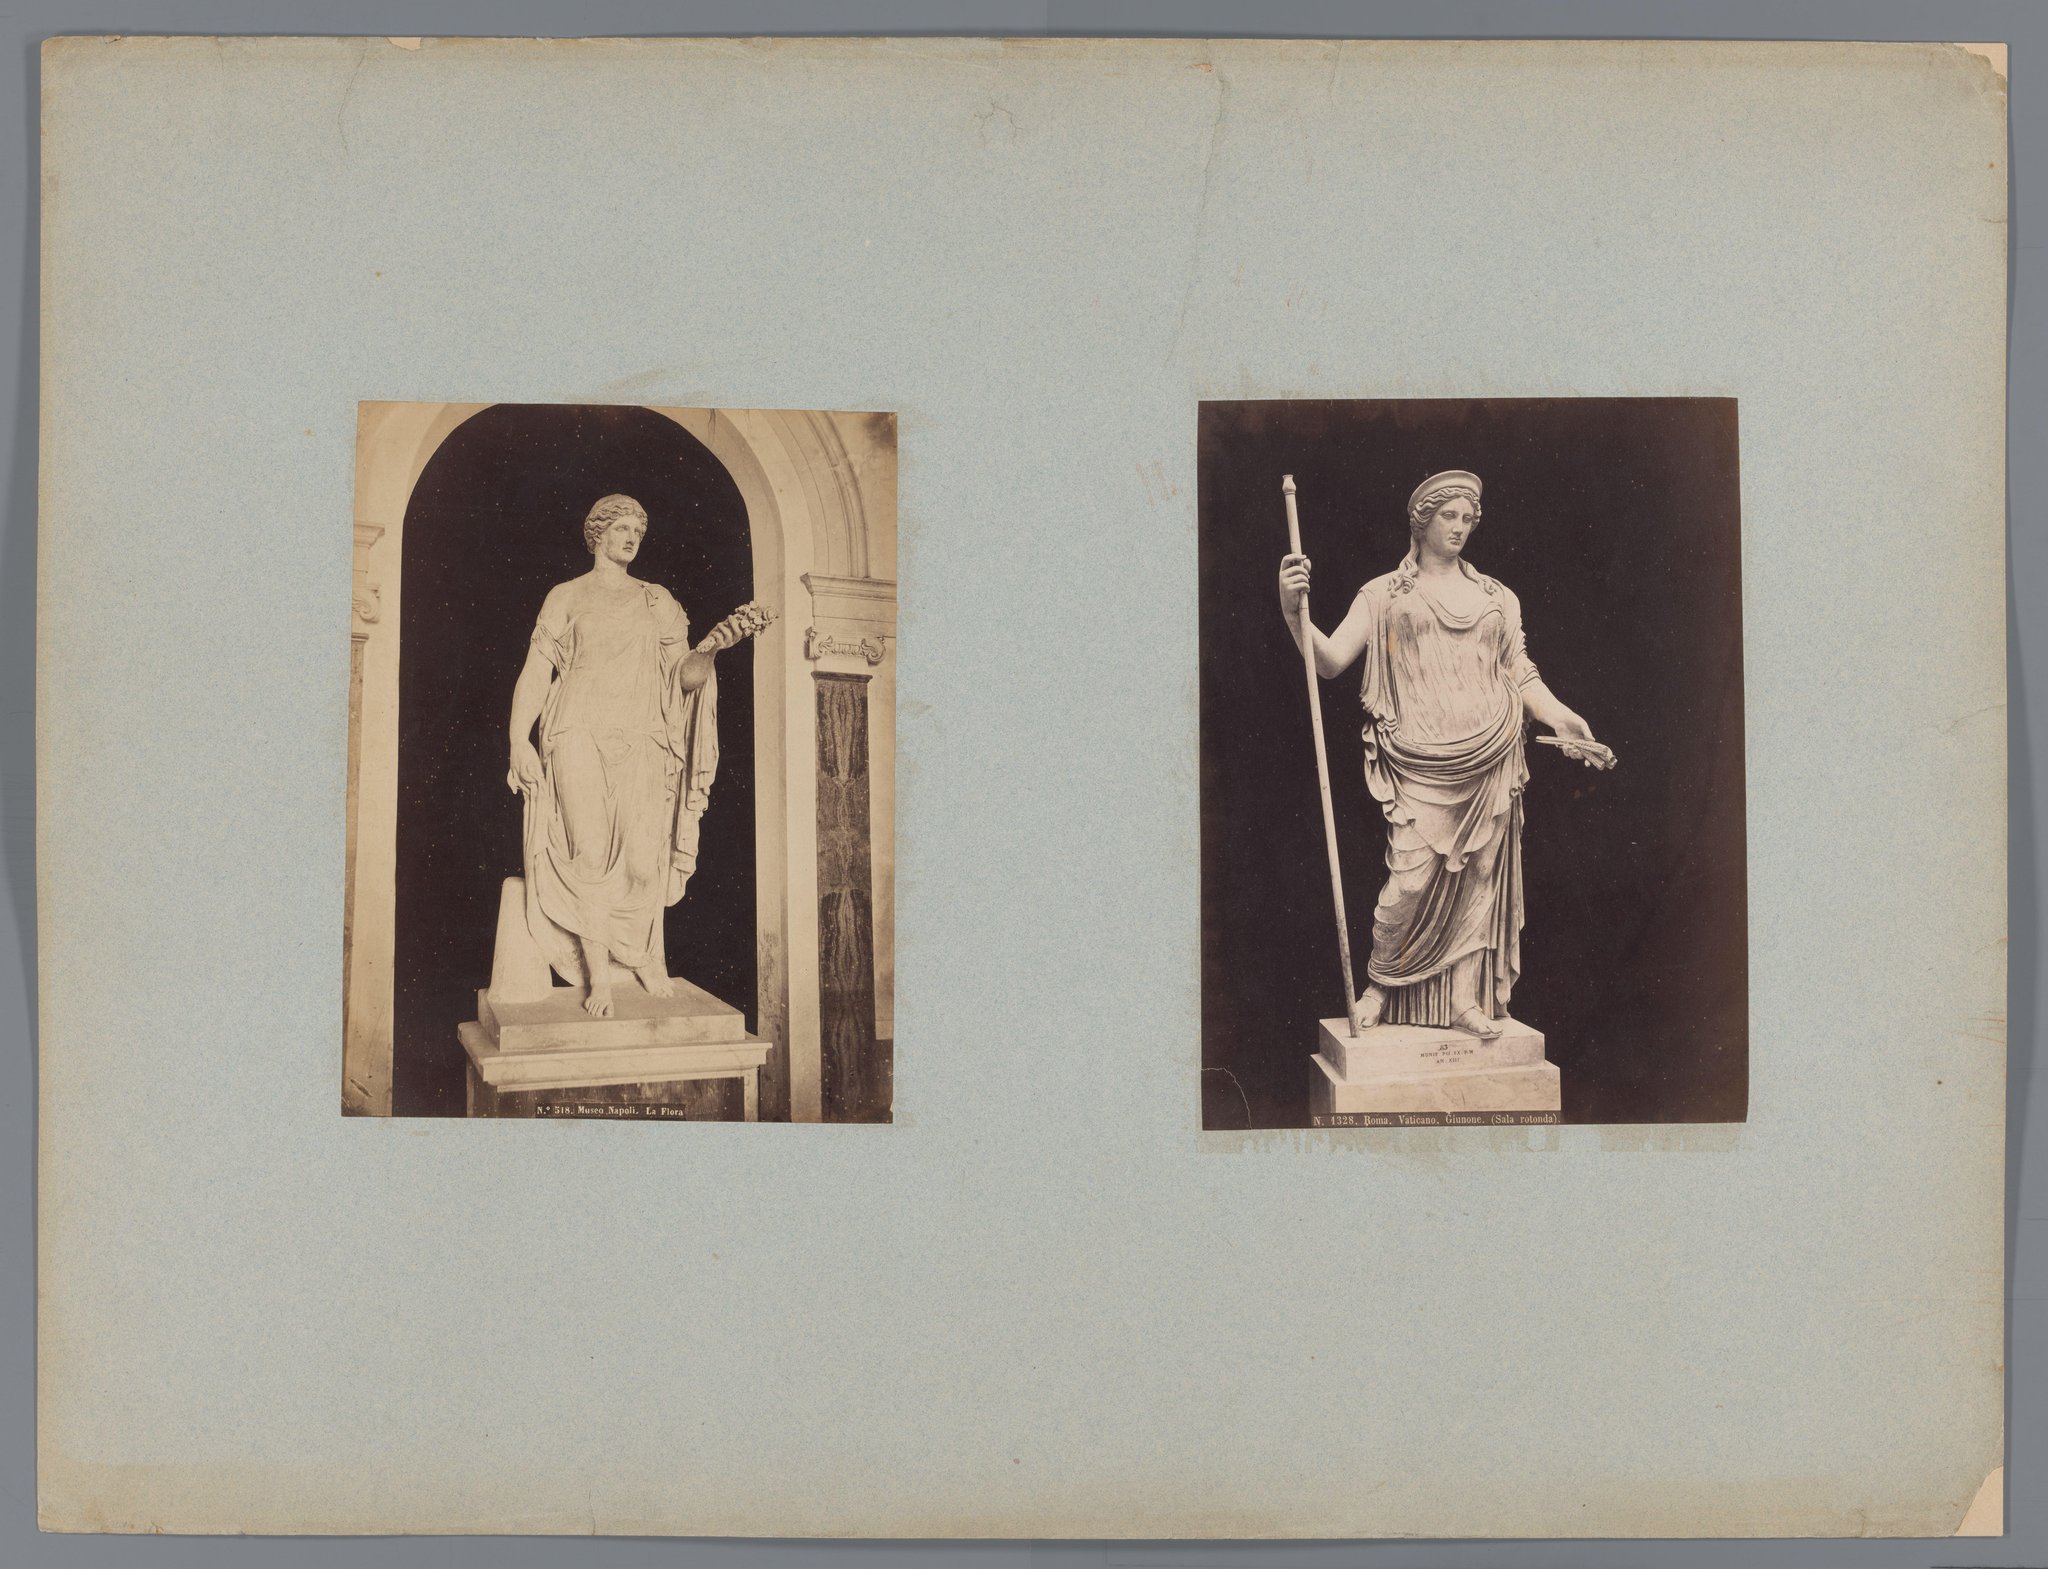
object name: photograph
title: Blad met twee foto's van sculpturen; Flora en Juno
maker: roberto rive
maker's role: fotograaf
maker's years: 1825-1868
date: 1860-1889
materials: cardboard, photographic support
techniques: albumen print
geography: italy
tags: naples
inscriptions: : ‘N. 1328. Roma. Vaticano. Giunone. (Sala rotonda).’, : ‘No. 518. Museo Napoli. La Flora’